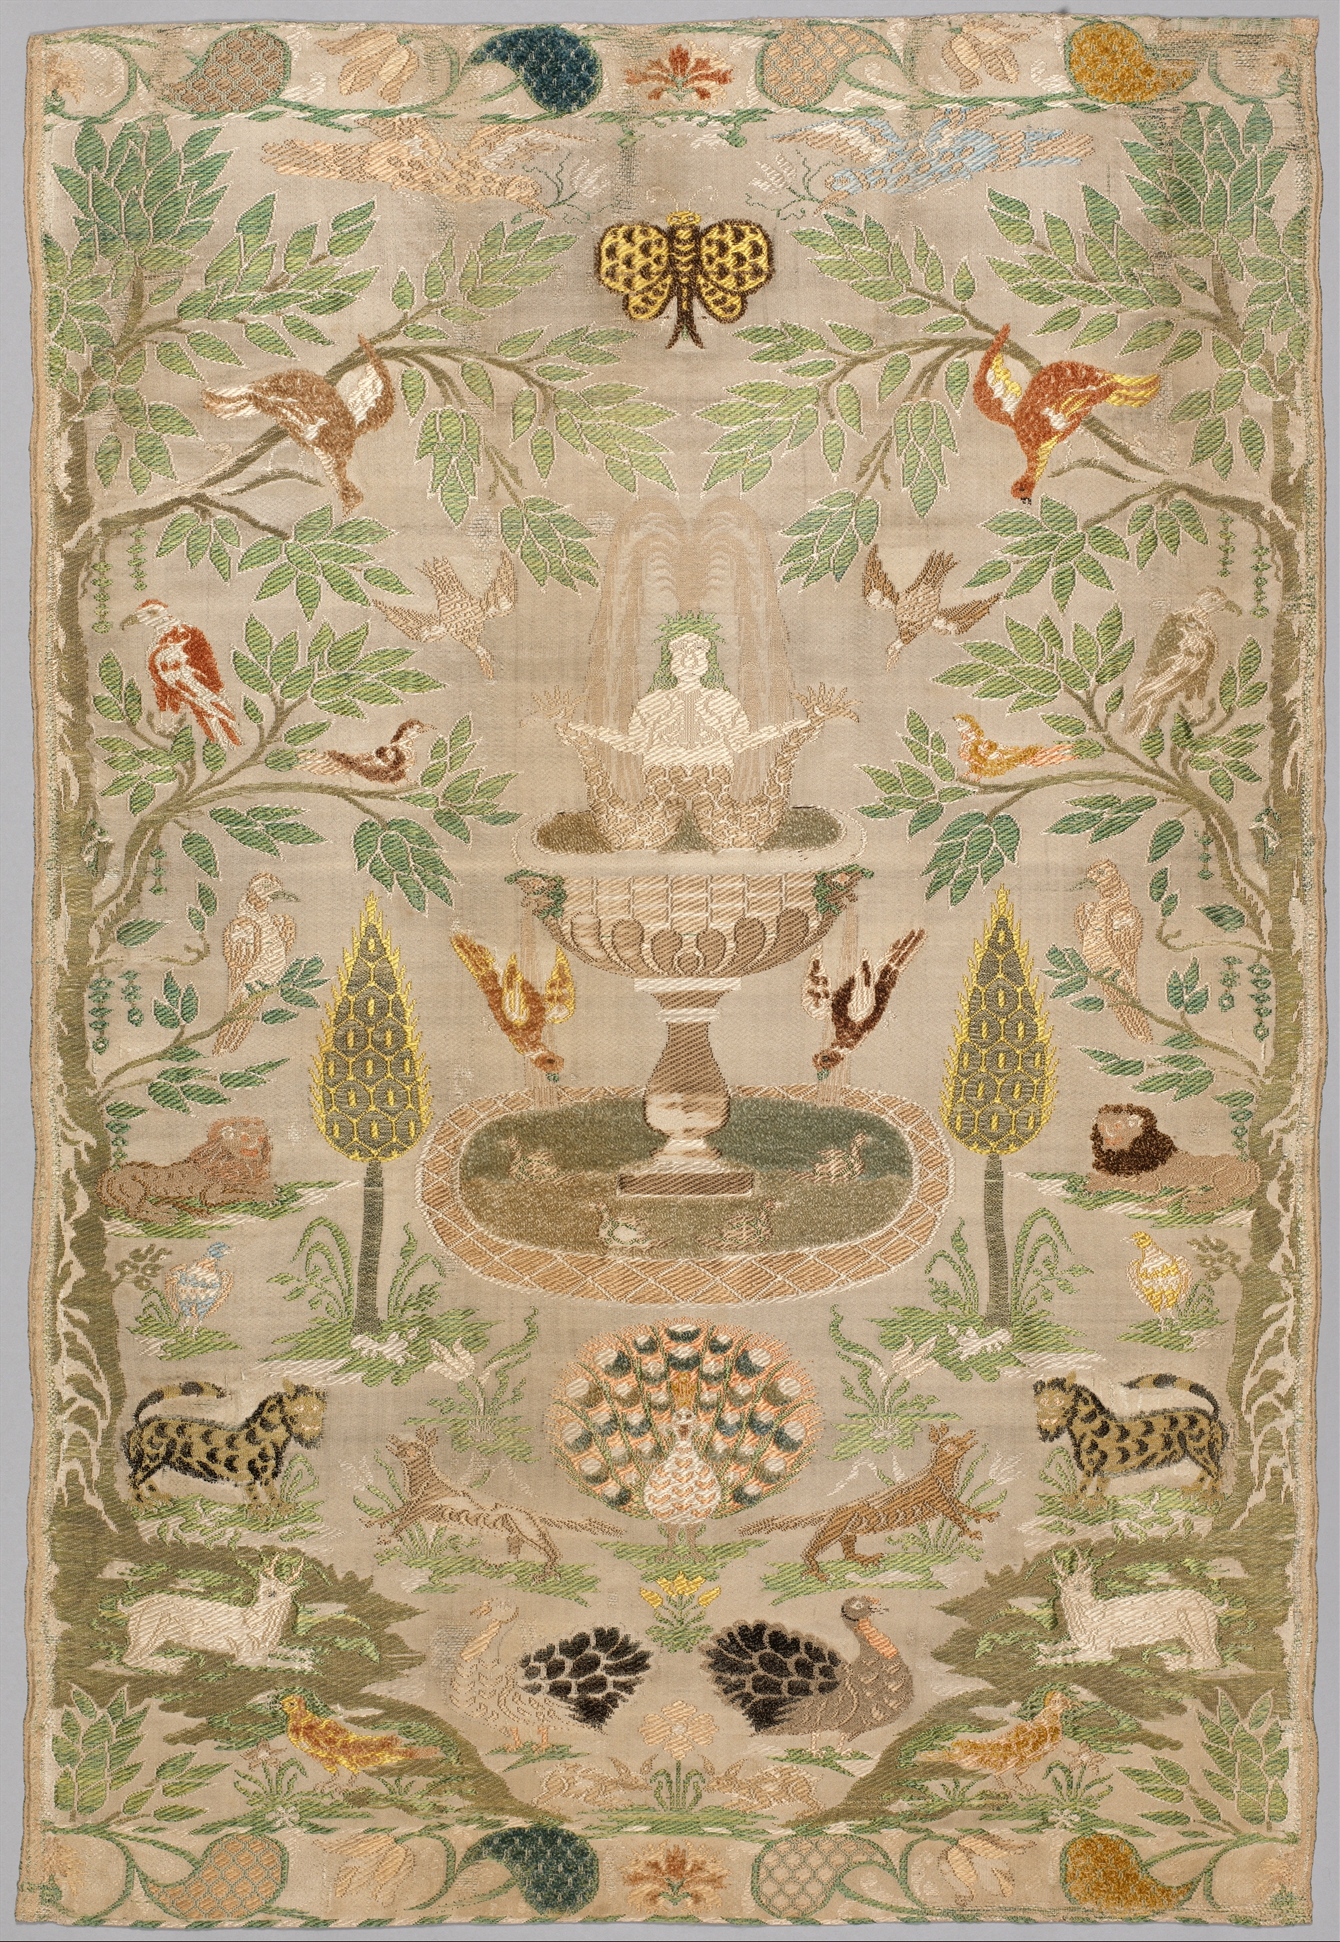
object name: panel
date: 1601-1800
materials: silk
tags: animals,birds,fountains,butterflies,trees